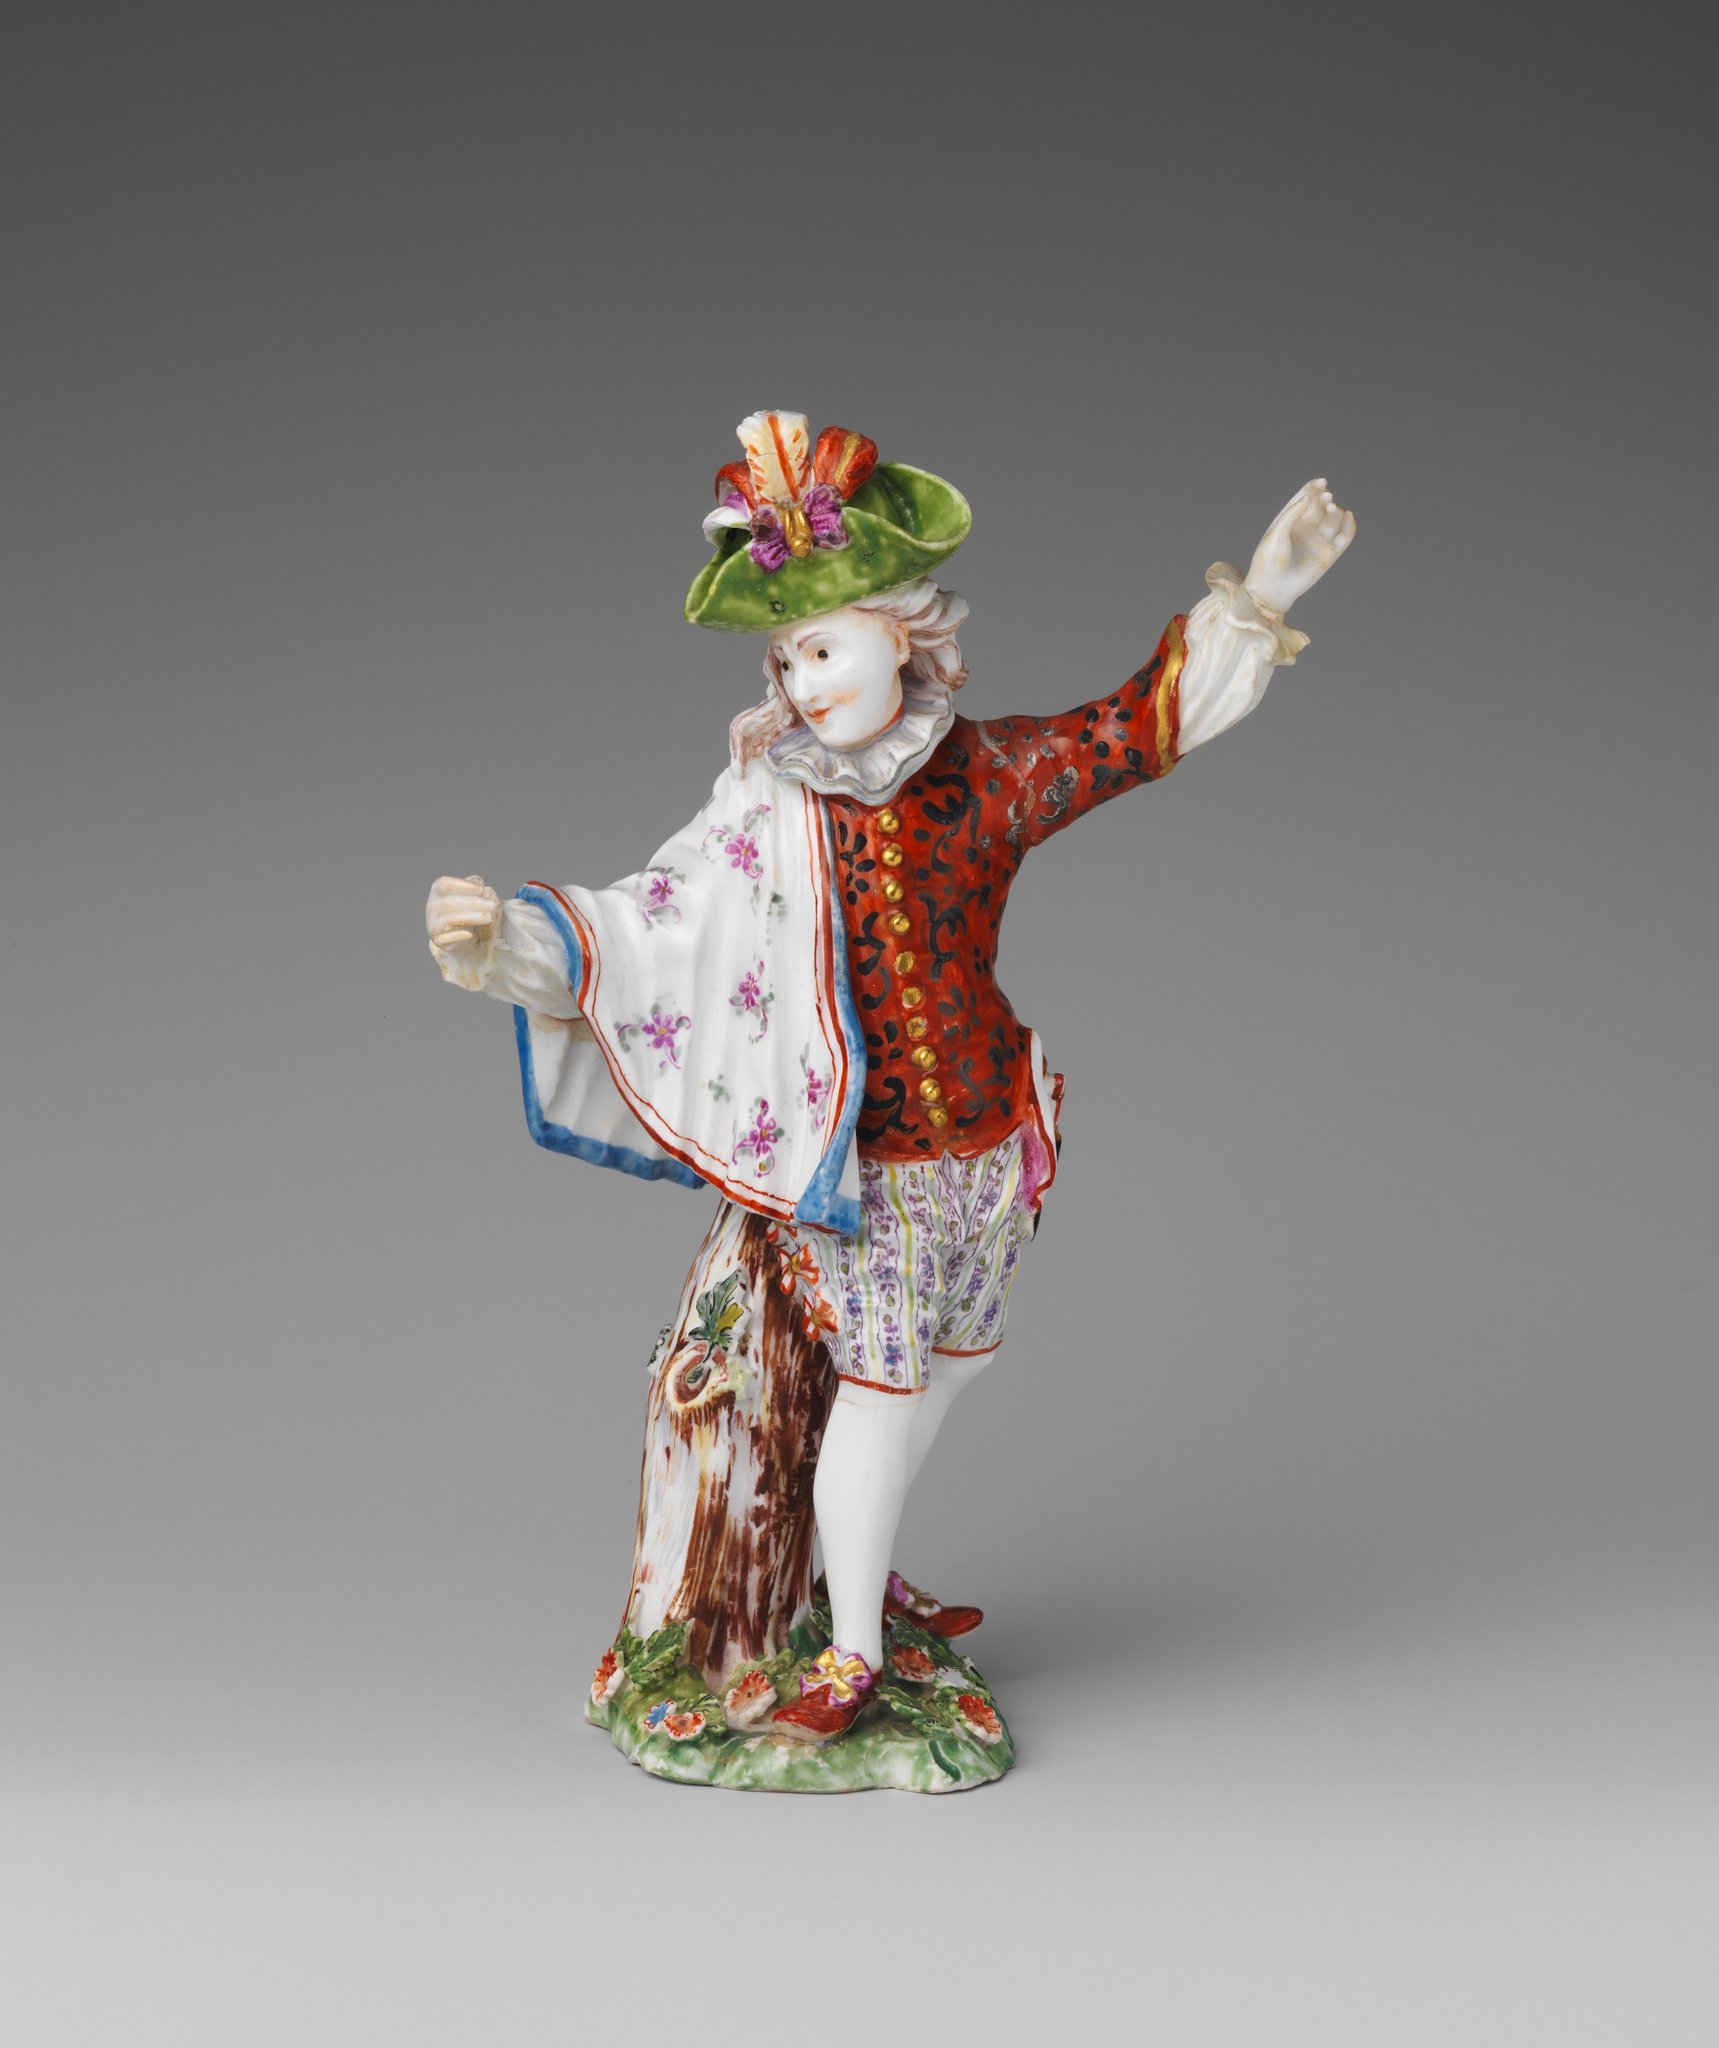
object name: figure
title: L' Indifférent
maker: vienna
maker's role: manufactory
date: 1741-1744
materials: hard paste porcelain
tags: men